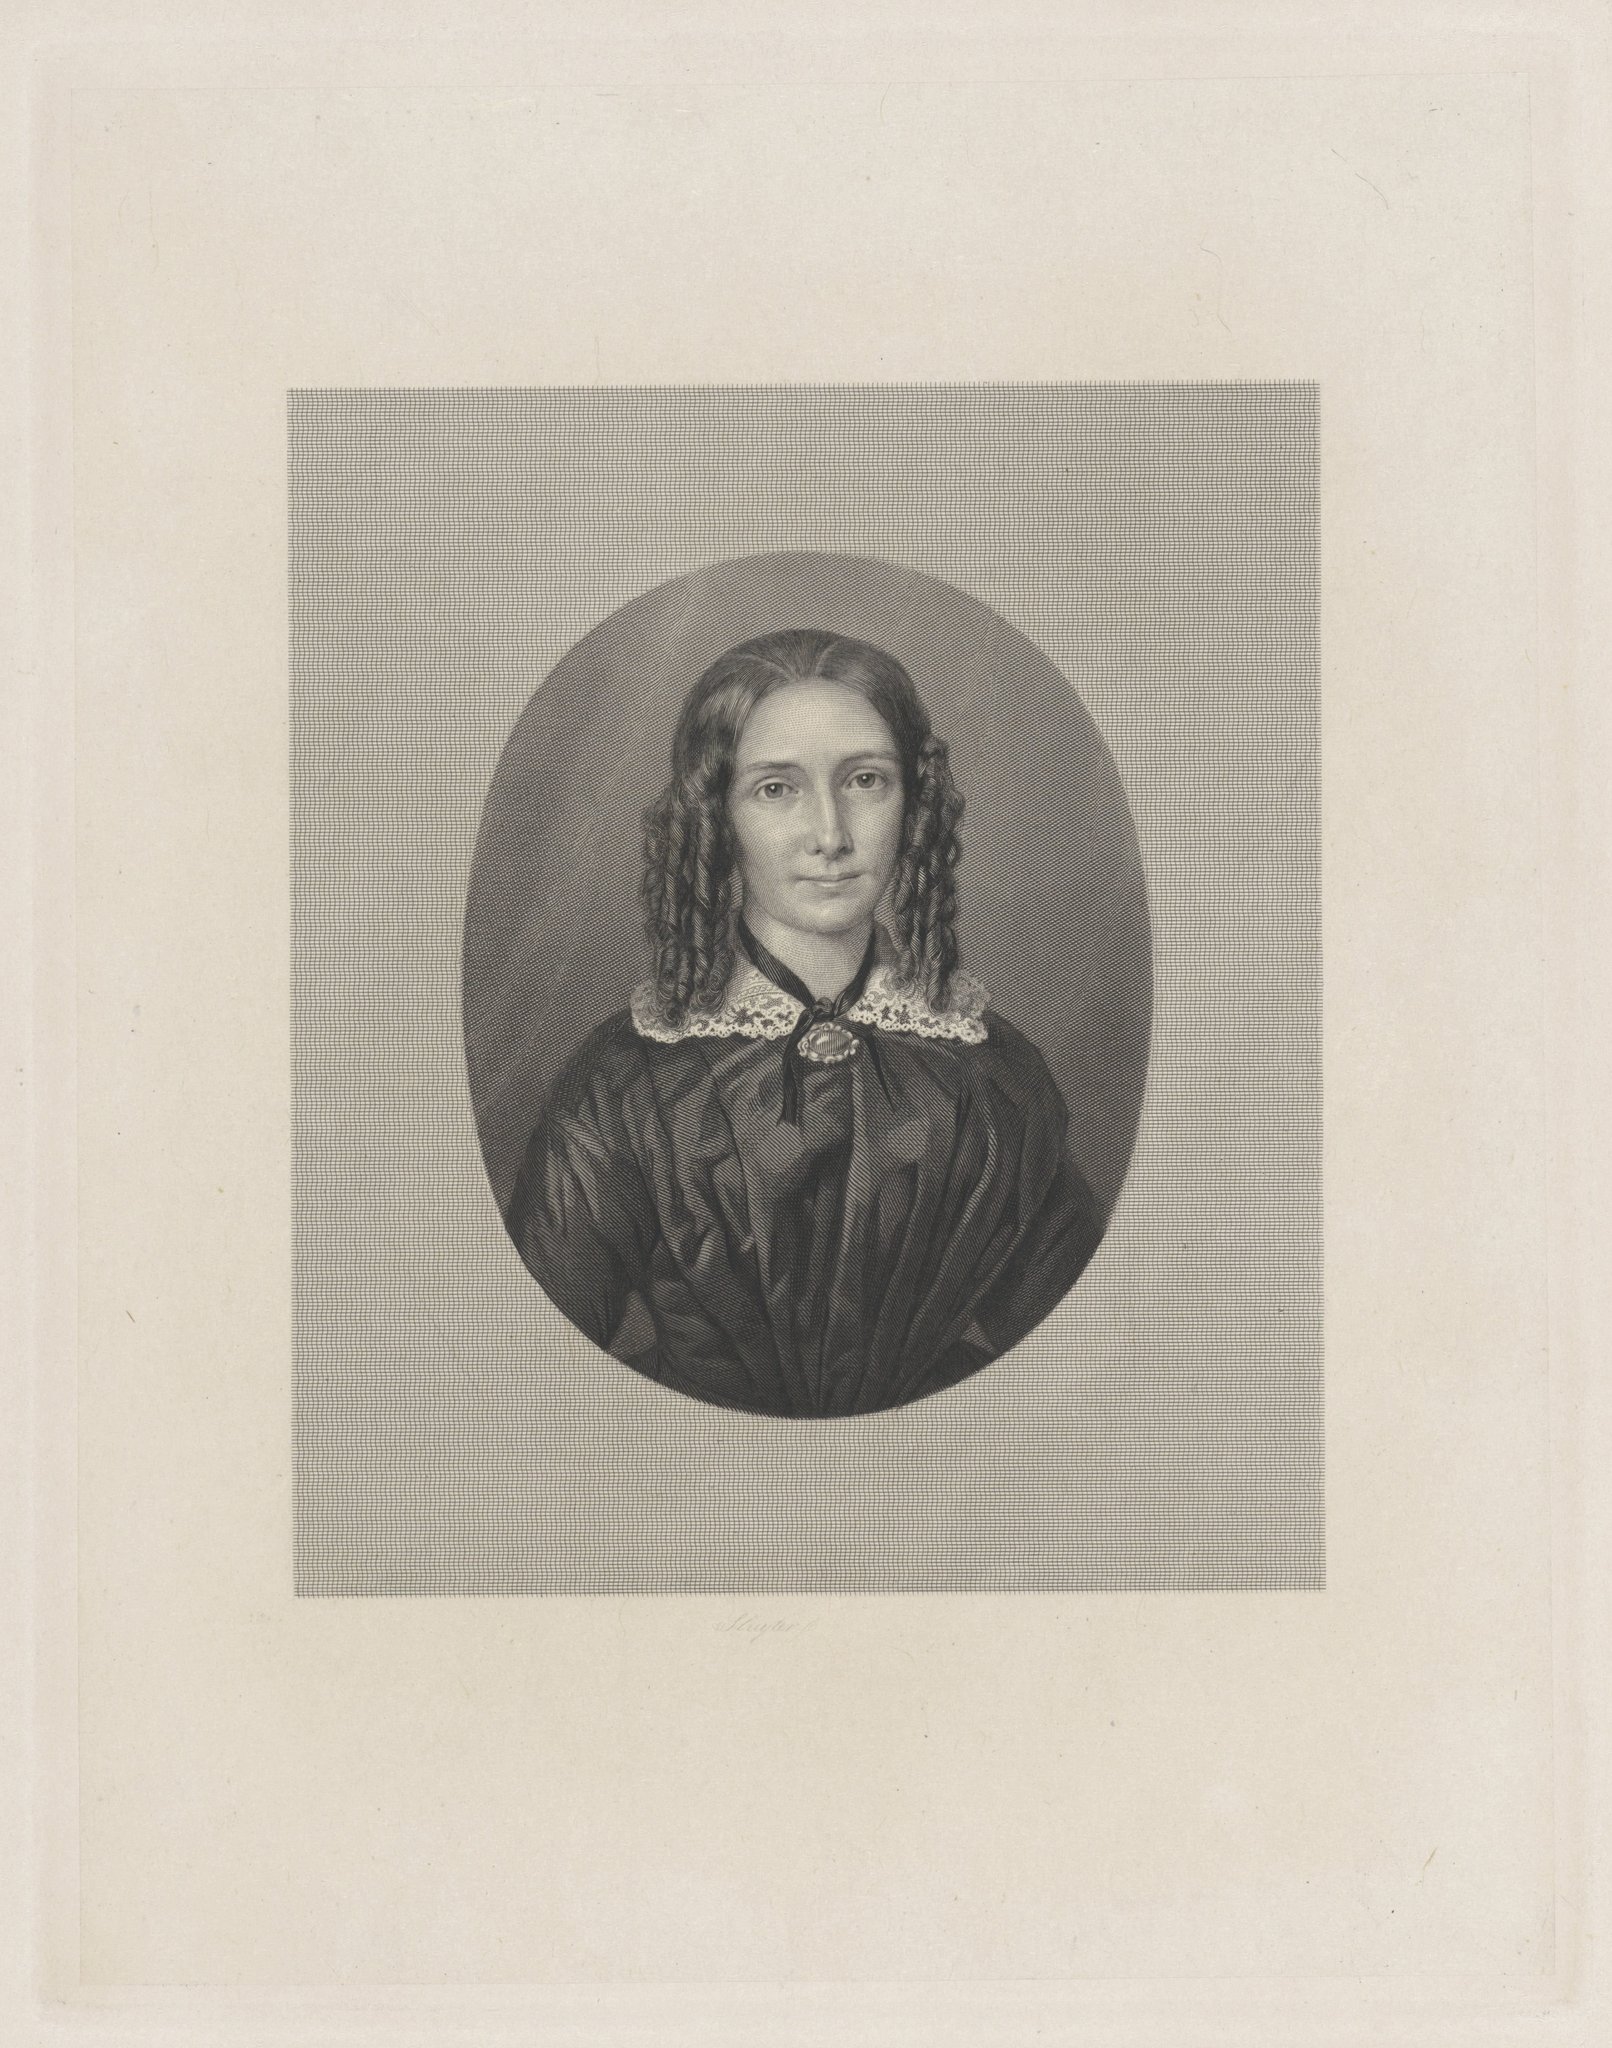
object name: print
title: Portret van Anna Louisa Geertruyda Bosboom-Toussaint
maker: dirk jurriaan sluyter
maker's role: draughtsman, print maker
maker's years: 1811-1886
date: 1860-1879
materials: paper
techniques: etching, engraving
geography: amsterdam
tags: the hague, anna louisa geertruyda bosboom-toussaint, portrait of a writer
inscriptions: collector's mark: Lugt 2228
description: Portret van de schrijfster Anna Louisa Geertruyda Bosboom-Toussaint.